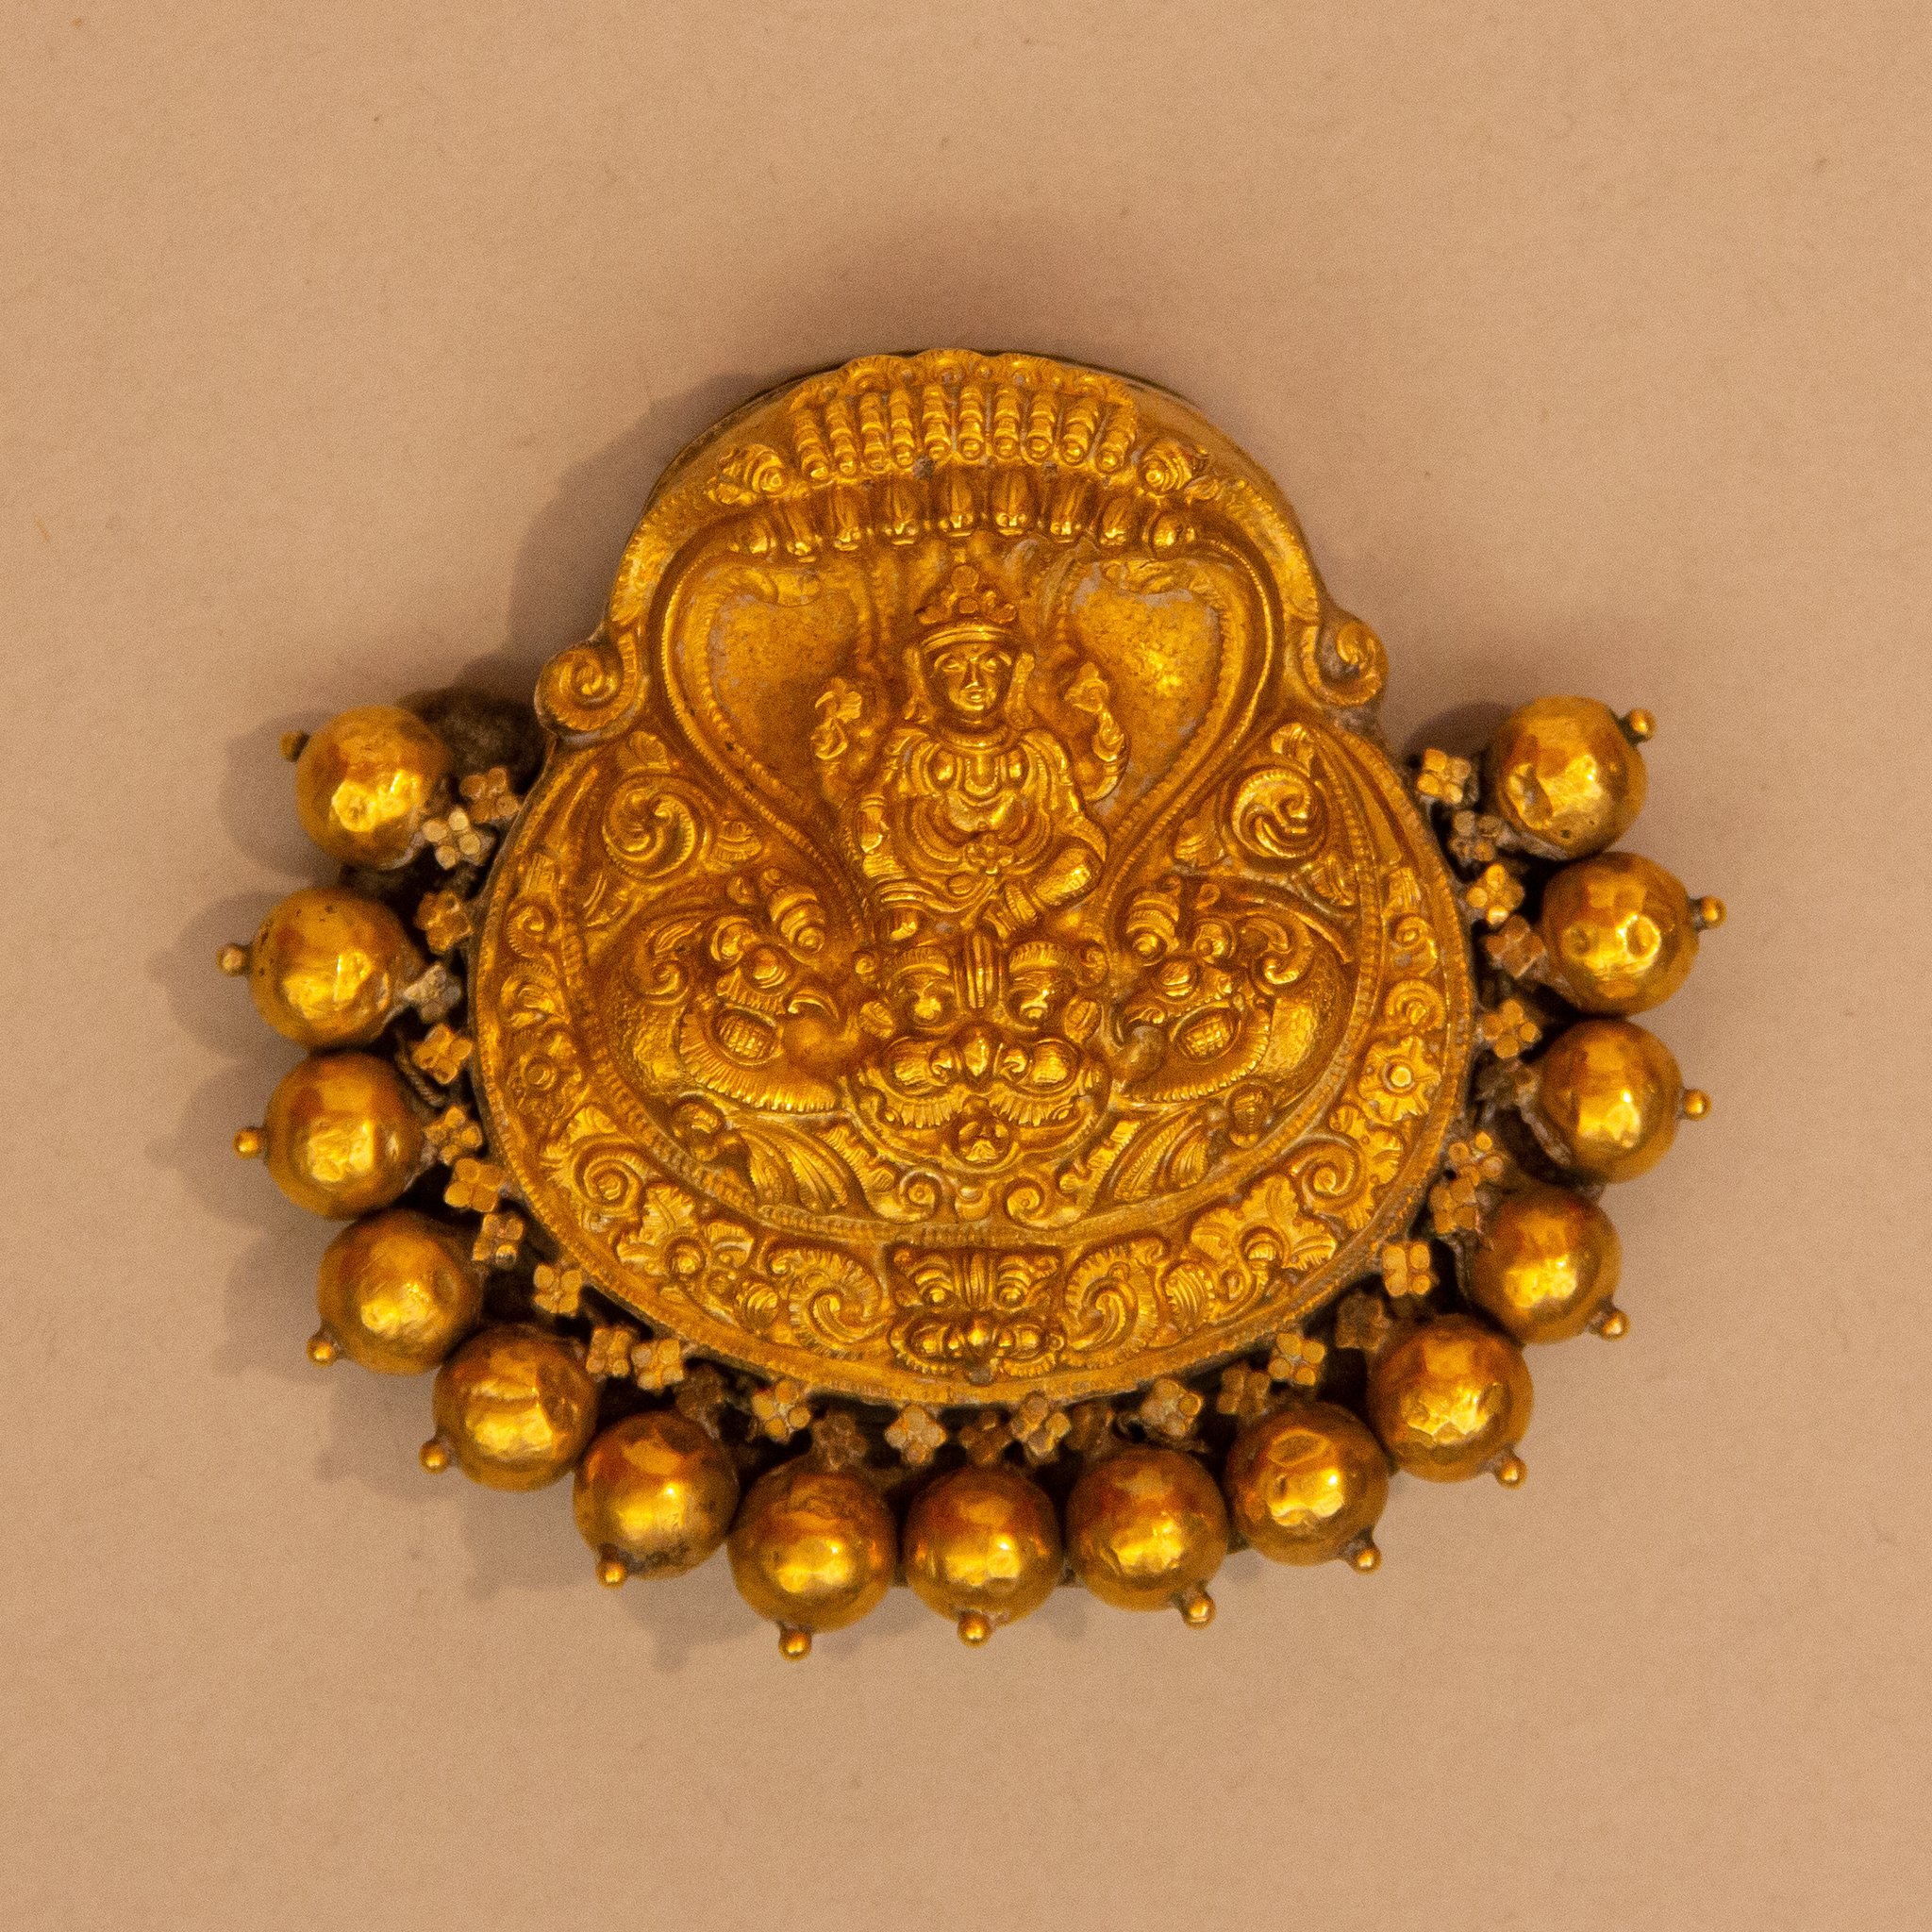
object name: hair ornament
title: Hair Ornament (Nagar)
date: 1801-1900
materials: gold, silver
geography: india